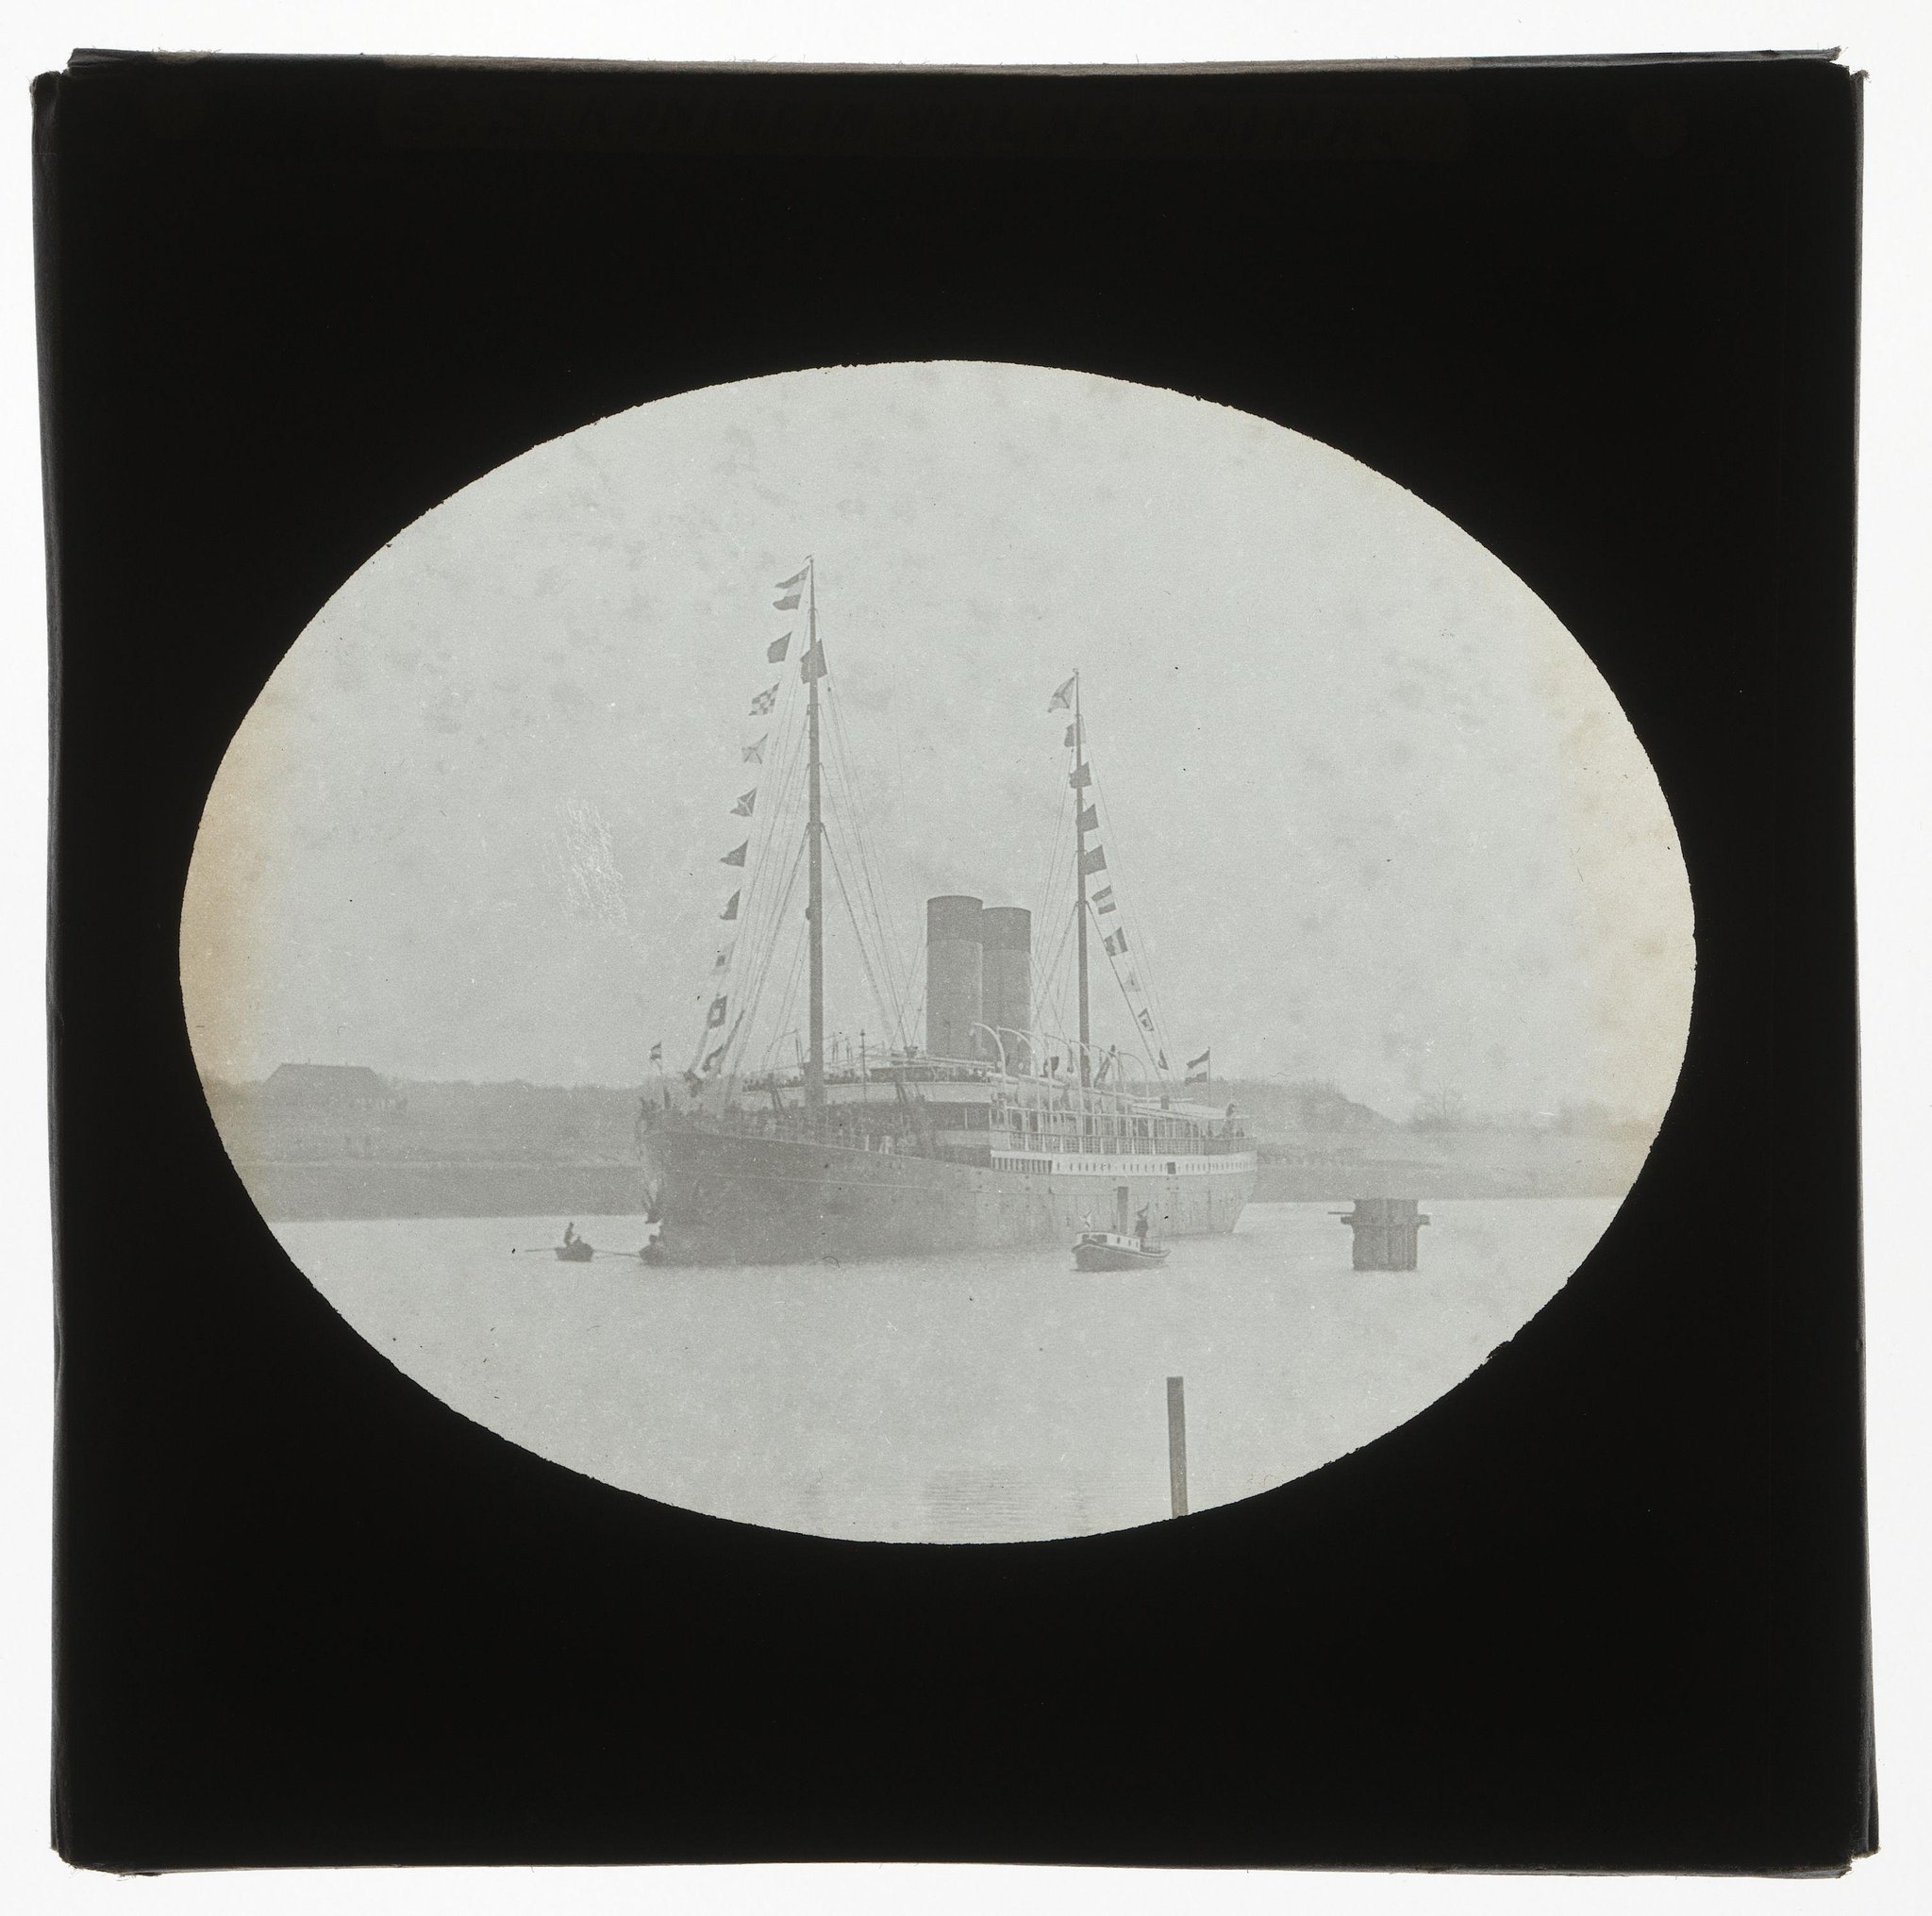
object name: lantern slide photographic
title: S.S. Koningin Wilhelmina te water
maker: machiel gerrit george suyver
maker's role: fotograaf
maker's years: 1872-1933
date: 1896-1898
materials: glass, paper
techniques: gelatin silver transparency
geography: netherlands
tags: steamship, motorship